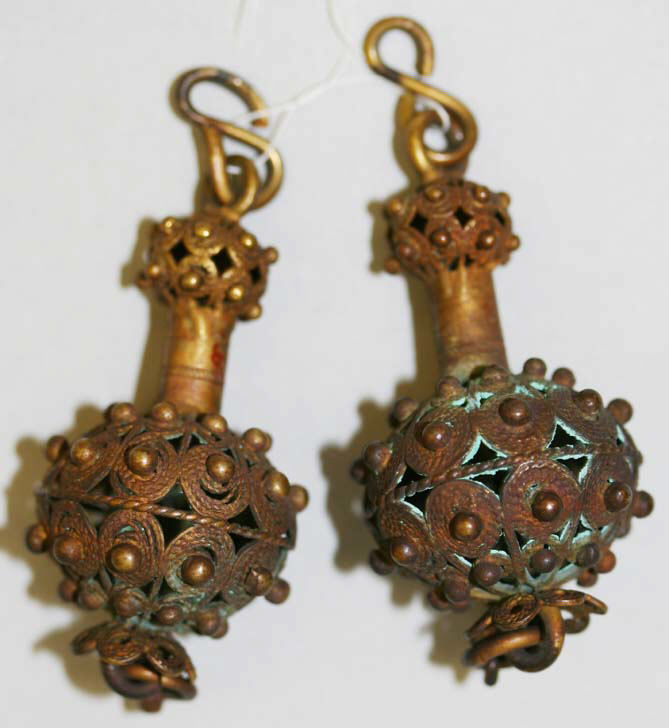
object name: earring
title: Earrings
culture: spanish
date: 1867-1933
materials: metal